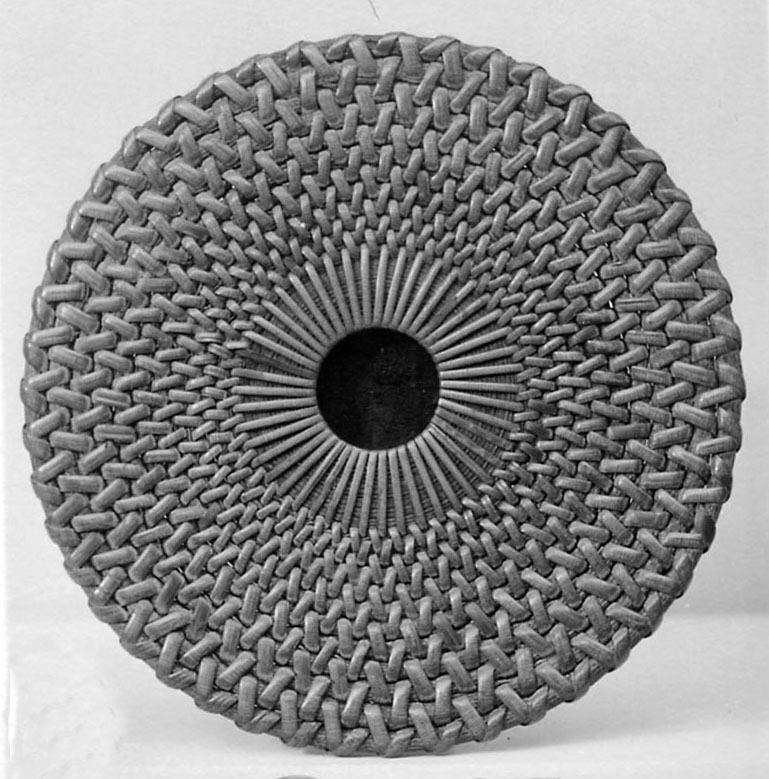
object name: mat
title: Kettle Mat (Kamashiki)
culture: japanese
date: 1775